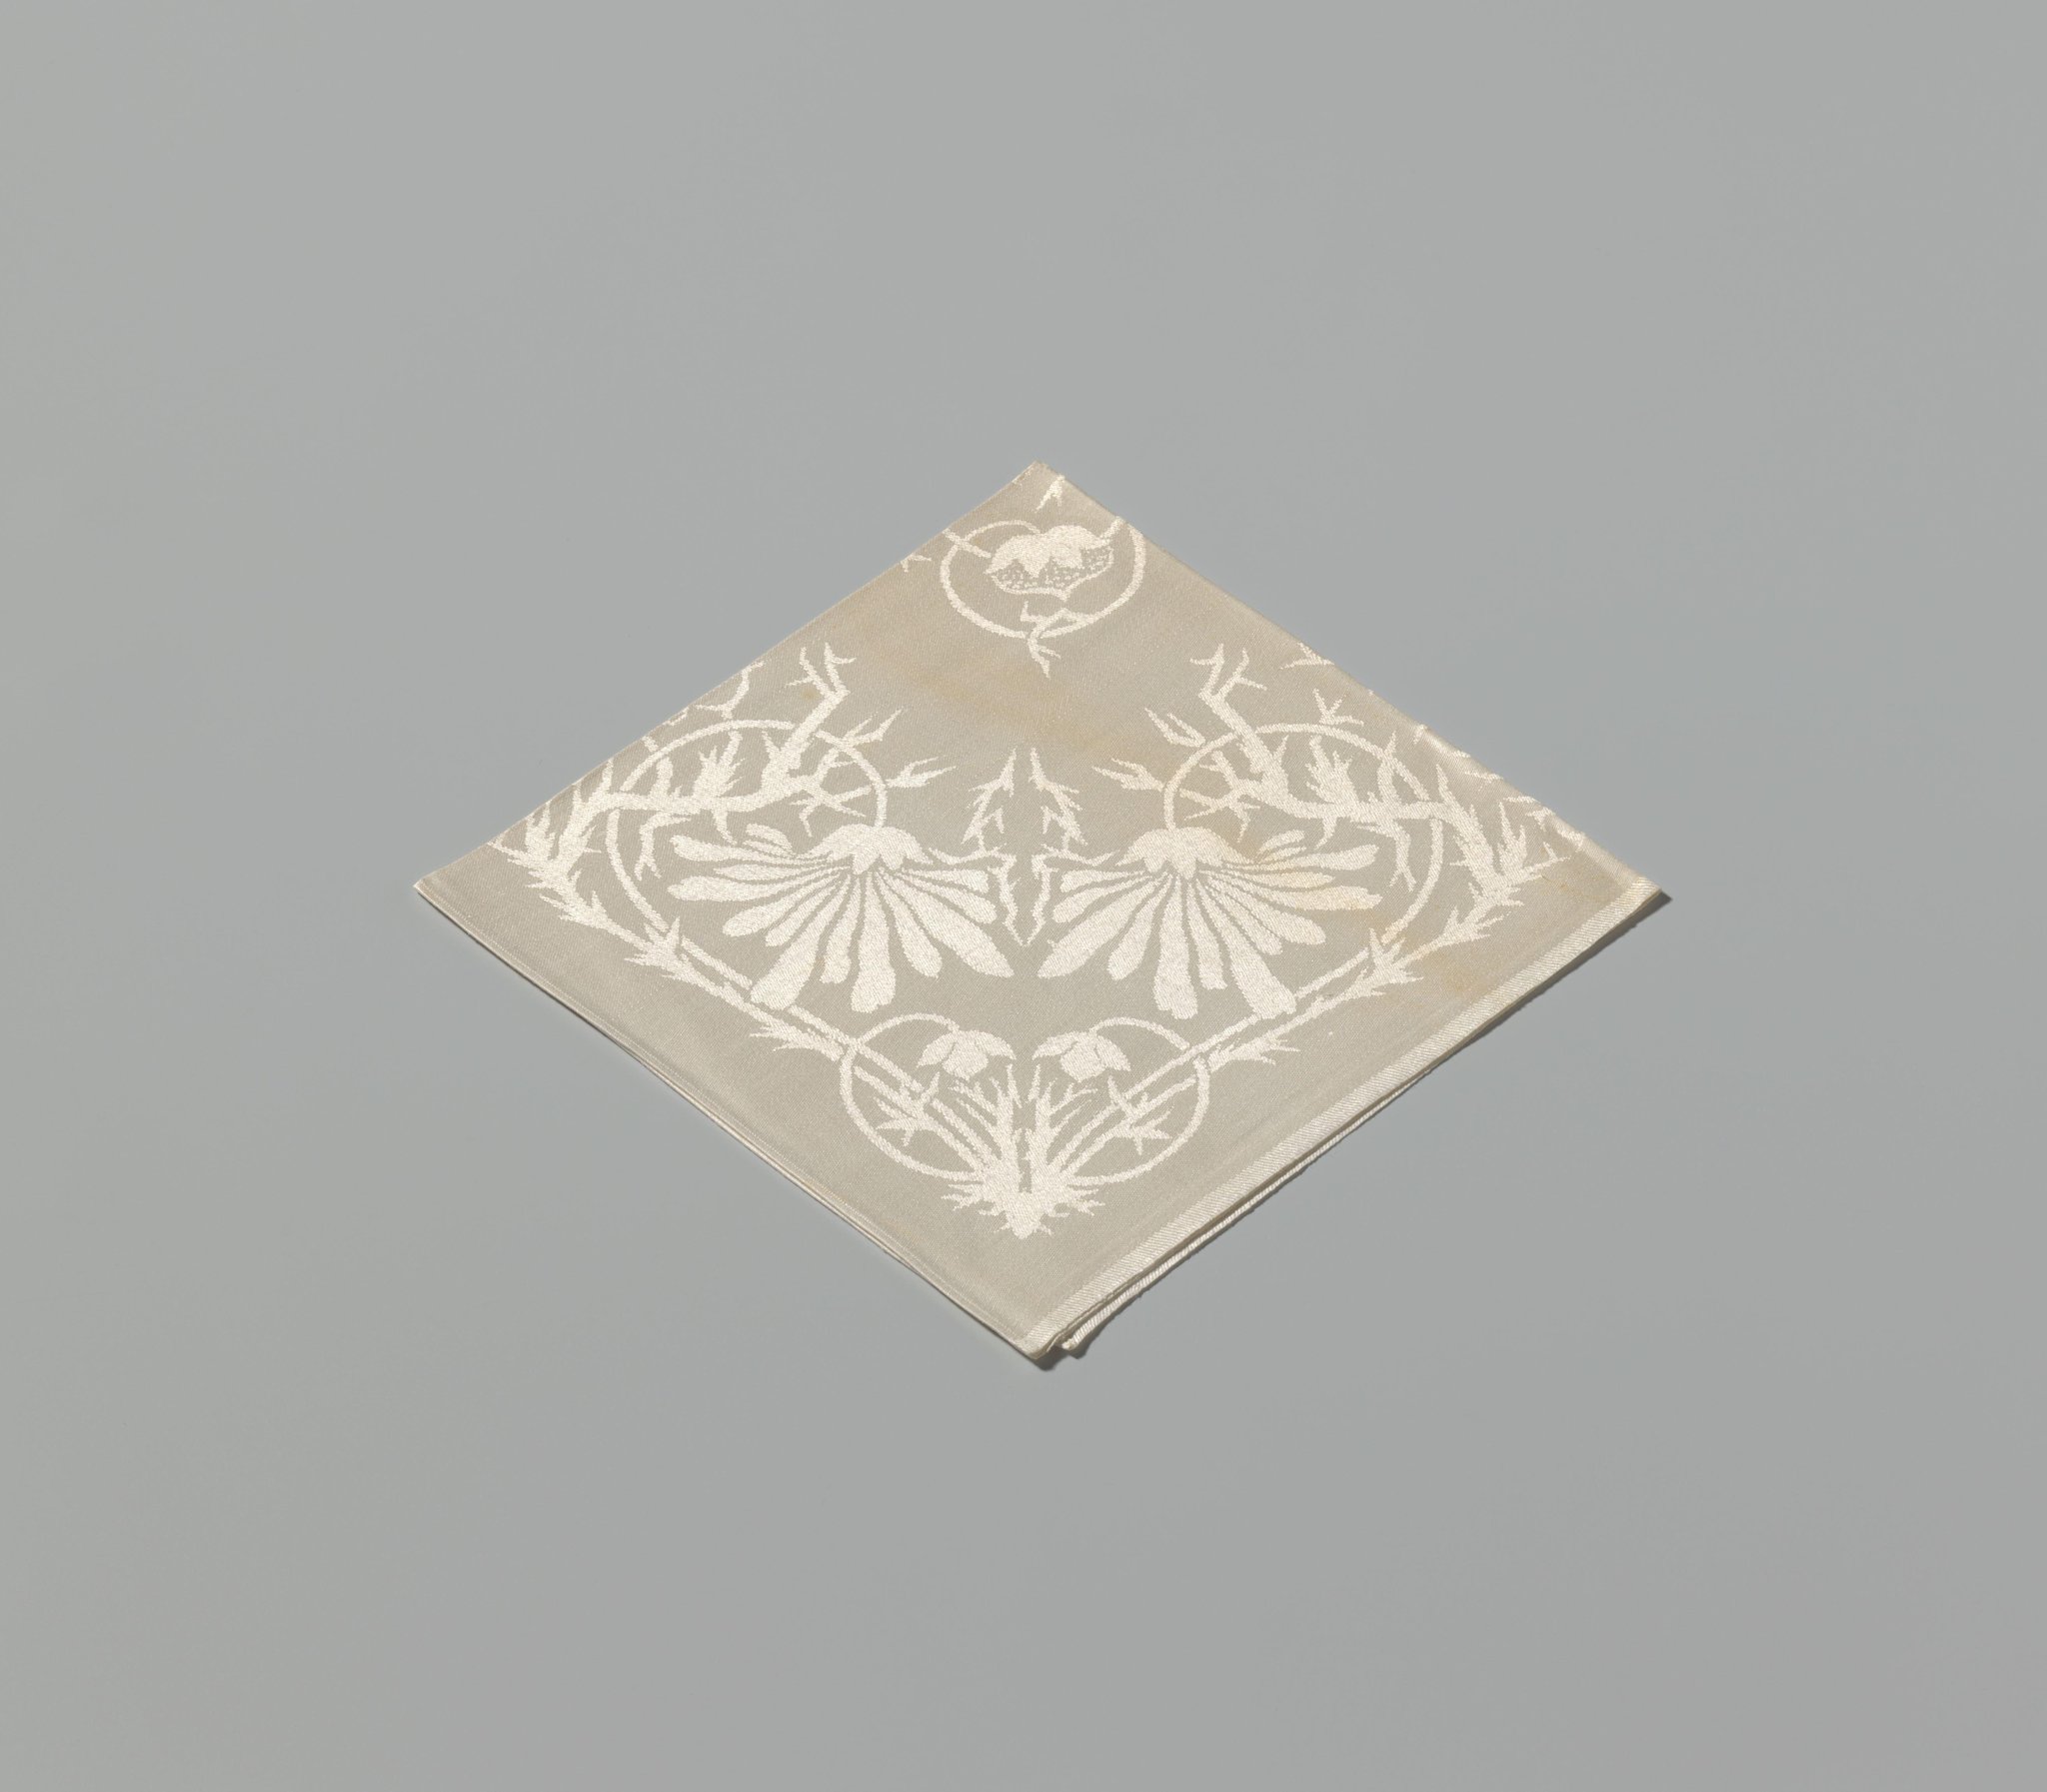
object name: vingerdoek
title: Vingerdoek van linnendamast met dessin Marguerite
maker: cornelis van der sluys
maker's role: print maker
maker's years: 1881-1944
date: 1904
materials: linen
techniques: damask, weave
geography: eindhoven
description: Vingerdoek van linnendamast met een bloempatroon: motief Marguerite, dessin nr. 500. De vingerdoek hoort bij elf vingerdoeken, dertien servetten en een tafellaken.